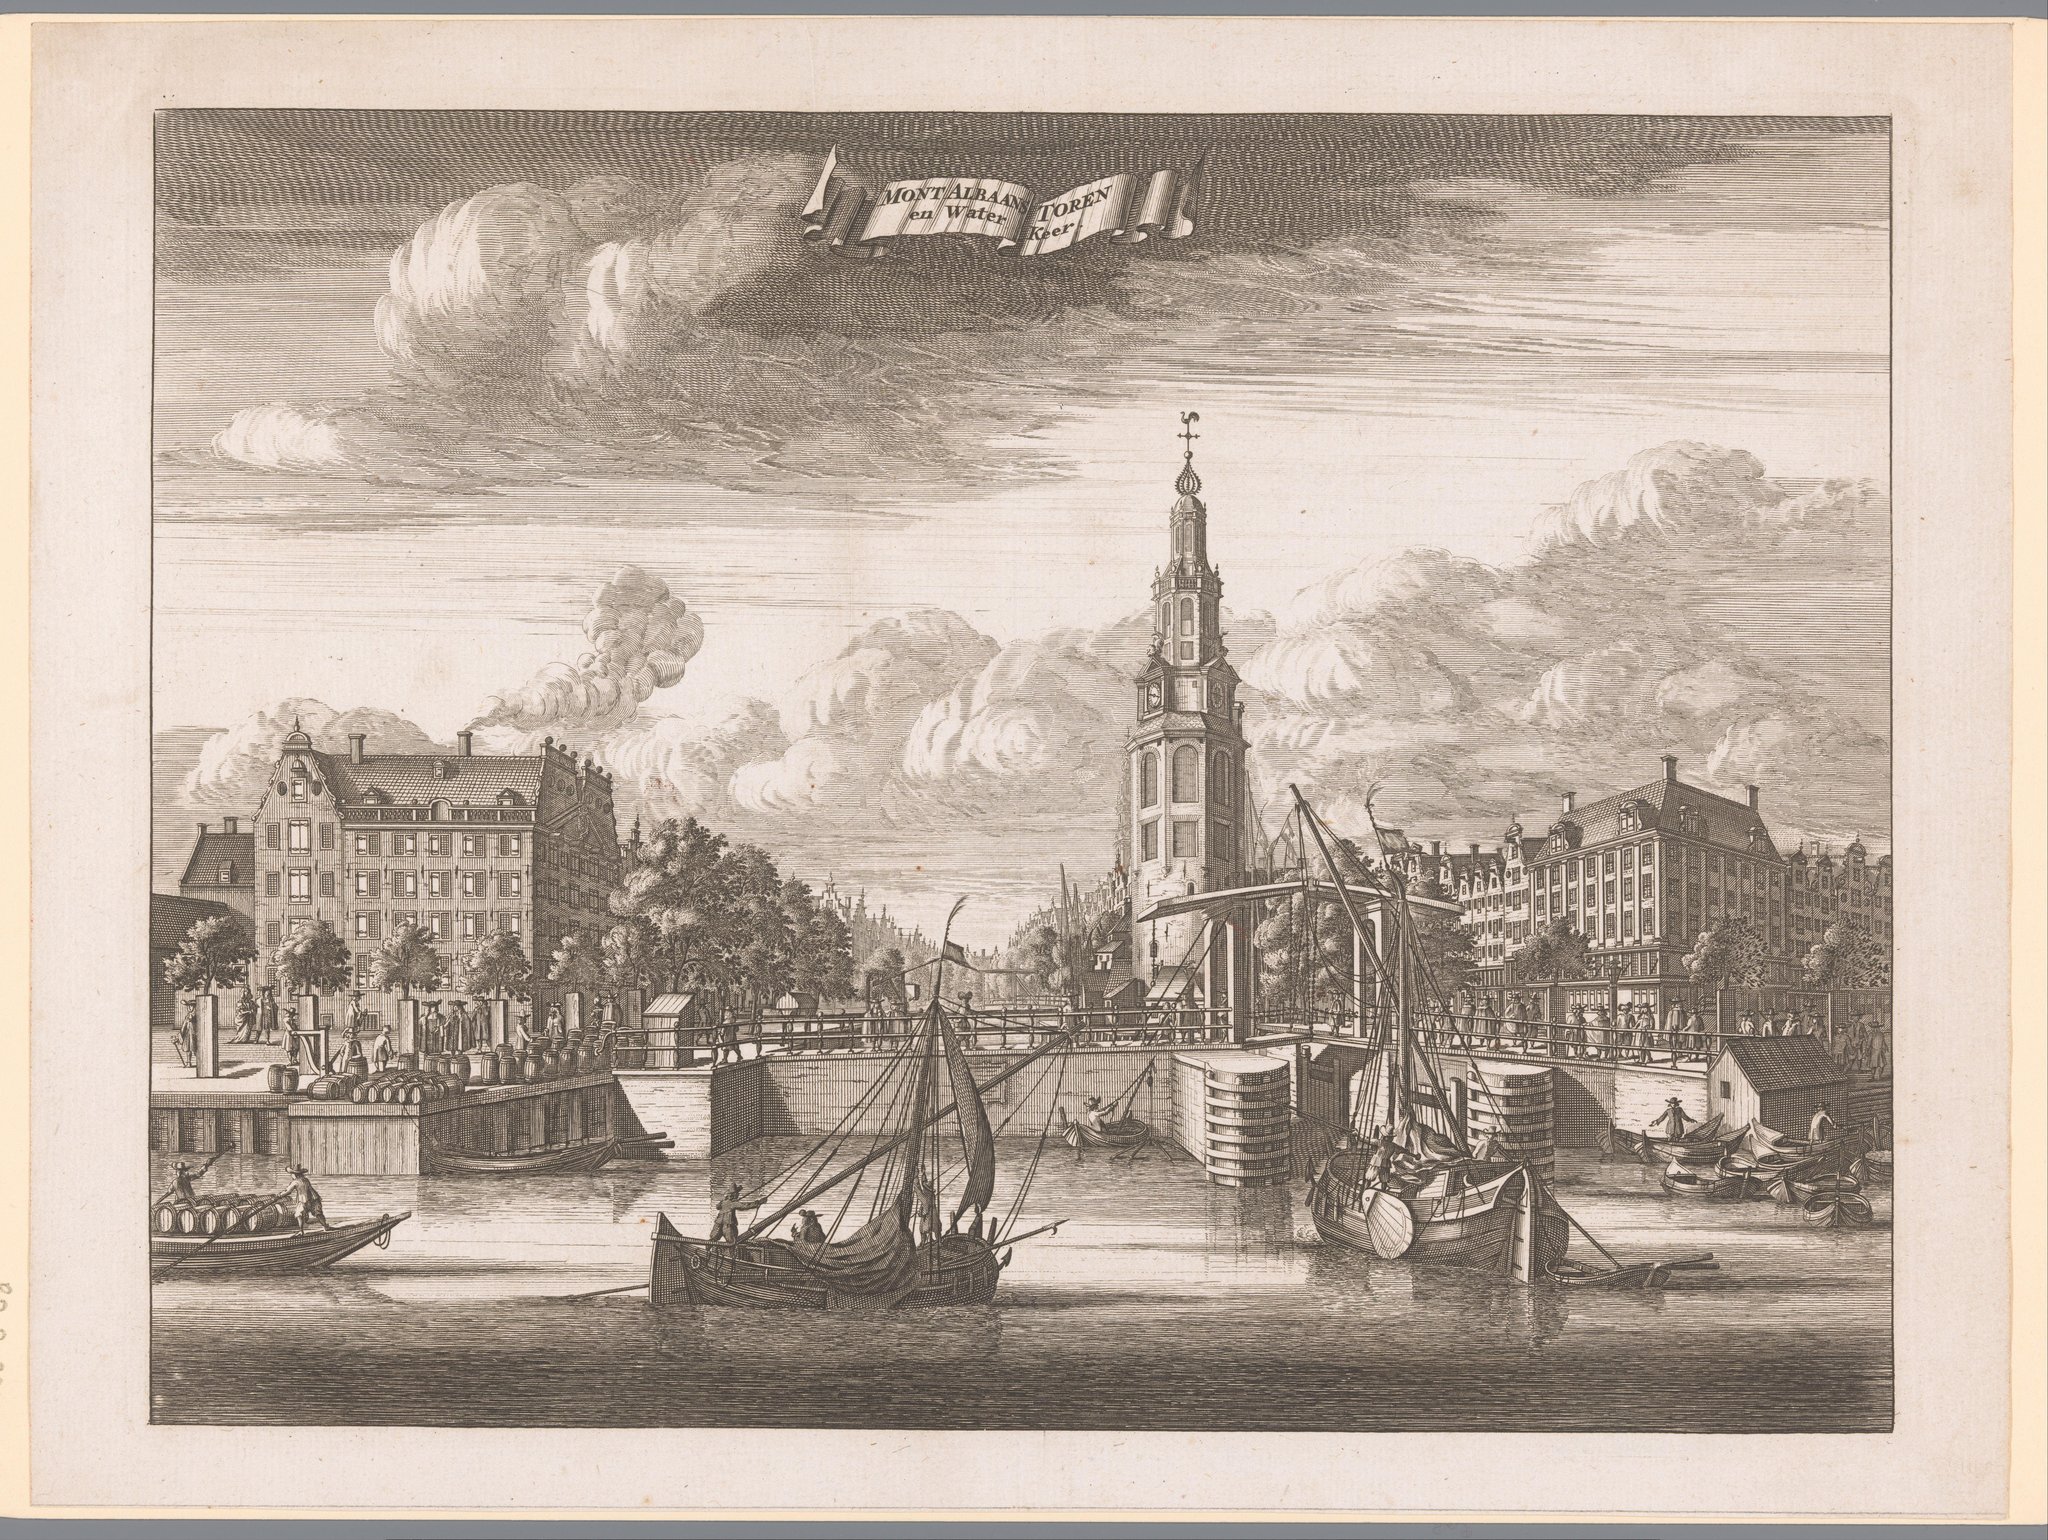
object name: book illustration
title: Gezicht op de Montelbaanstoren te Amsterdam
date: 1693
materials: paper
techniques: engraving, etching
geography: amsterdam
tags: urban housing, sailing-ship, sailing-boat, towers ~ fortified city, rowing-boat, canoe, etc., bridge in city across river, canal, etc.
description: Prent uit: Commelin, Caspar. Beschryvinge van Amsterdam (...). 2 dln. Amsterdam: Abraham Wolfgang et al., 1693, dl. 2, p. 706-707. En in latere edities van dit werk (Amsterdam: Weduwe Aart Dircksz. Oossaan, 1694 en Amsterdam: Andries van Damme et al., 1726).